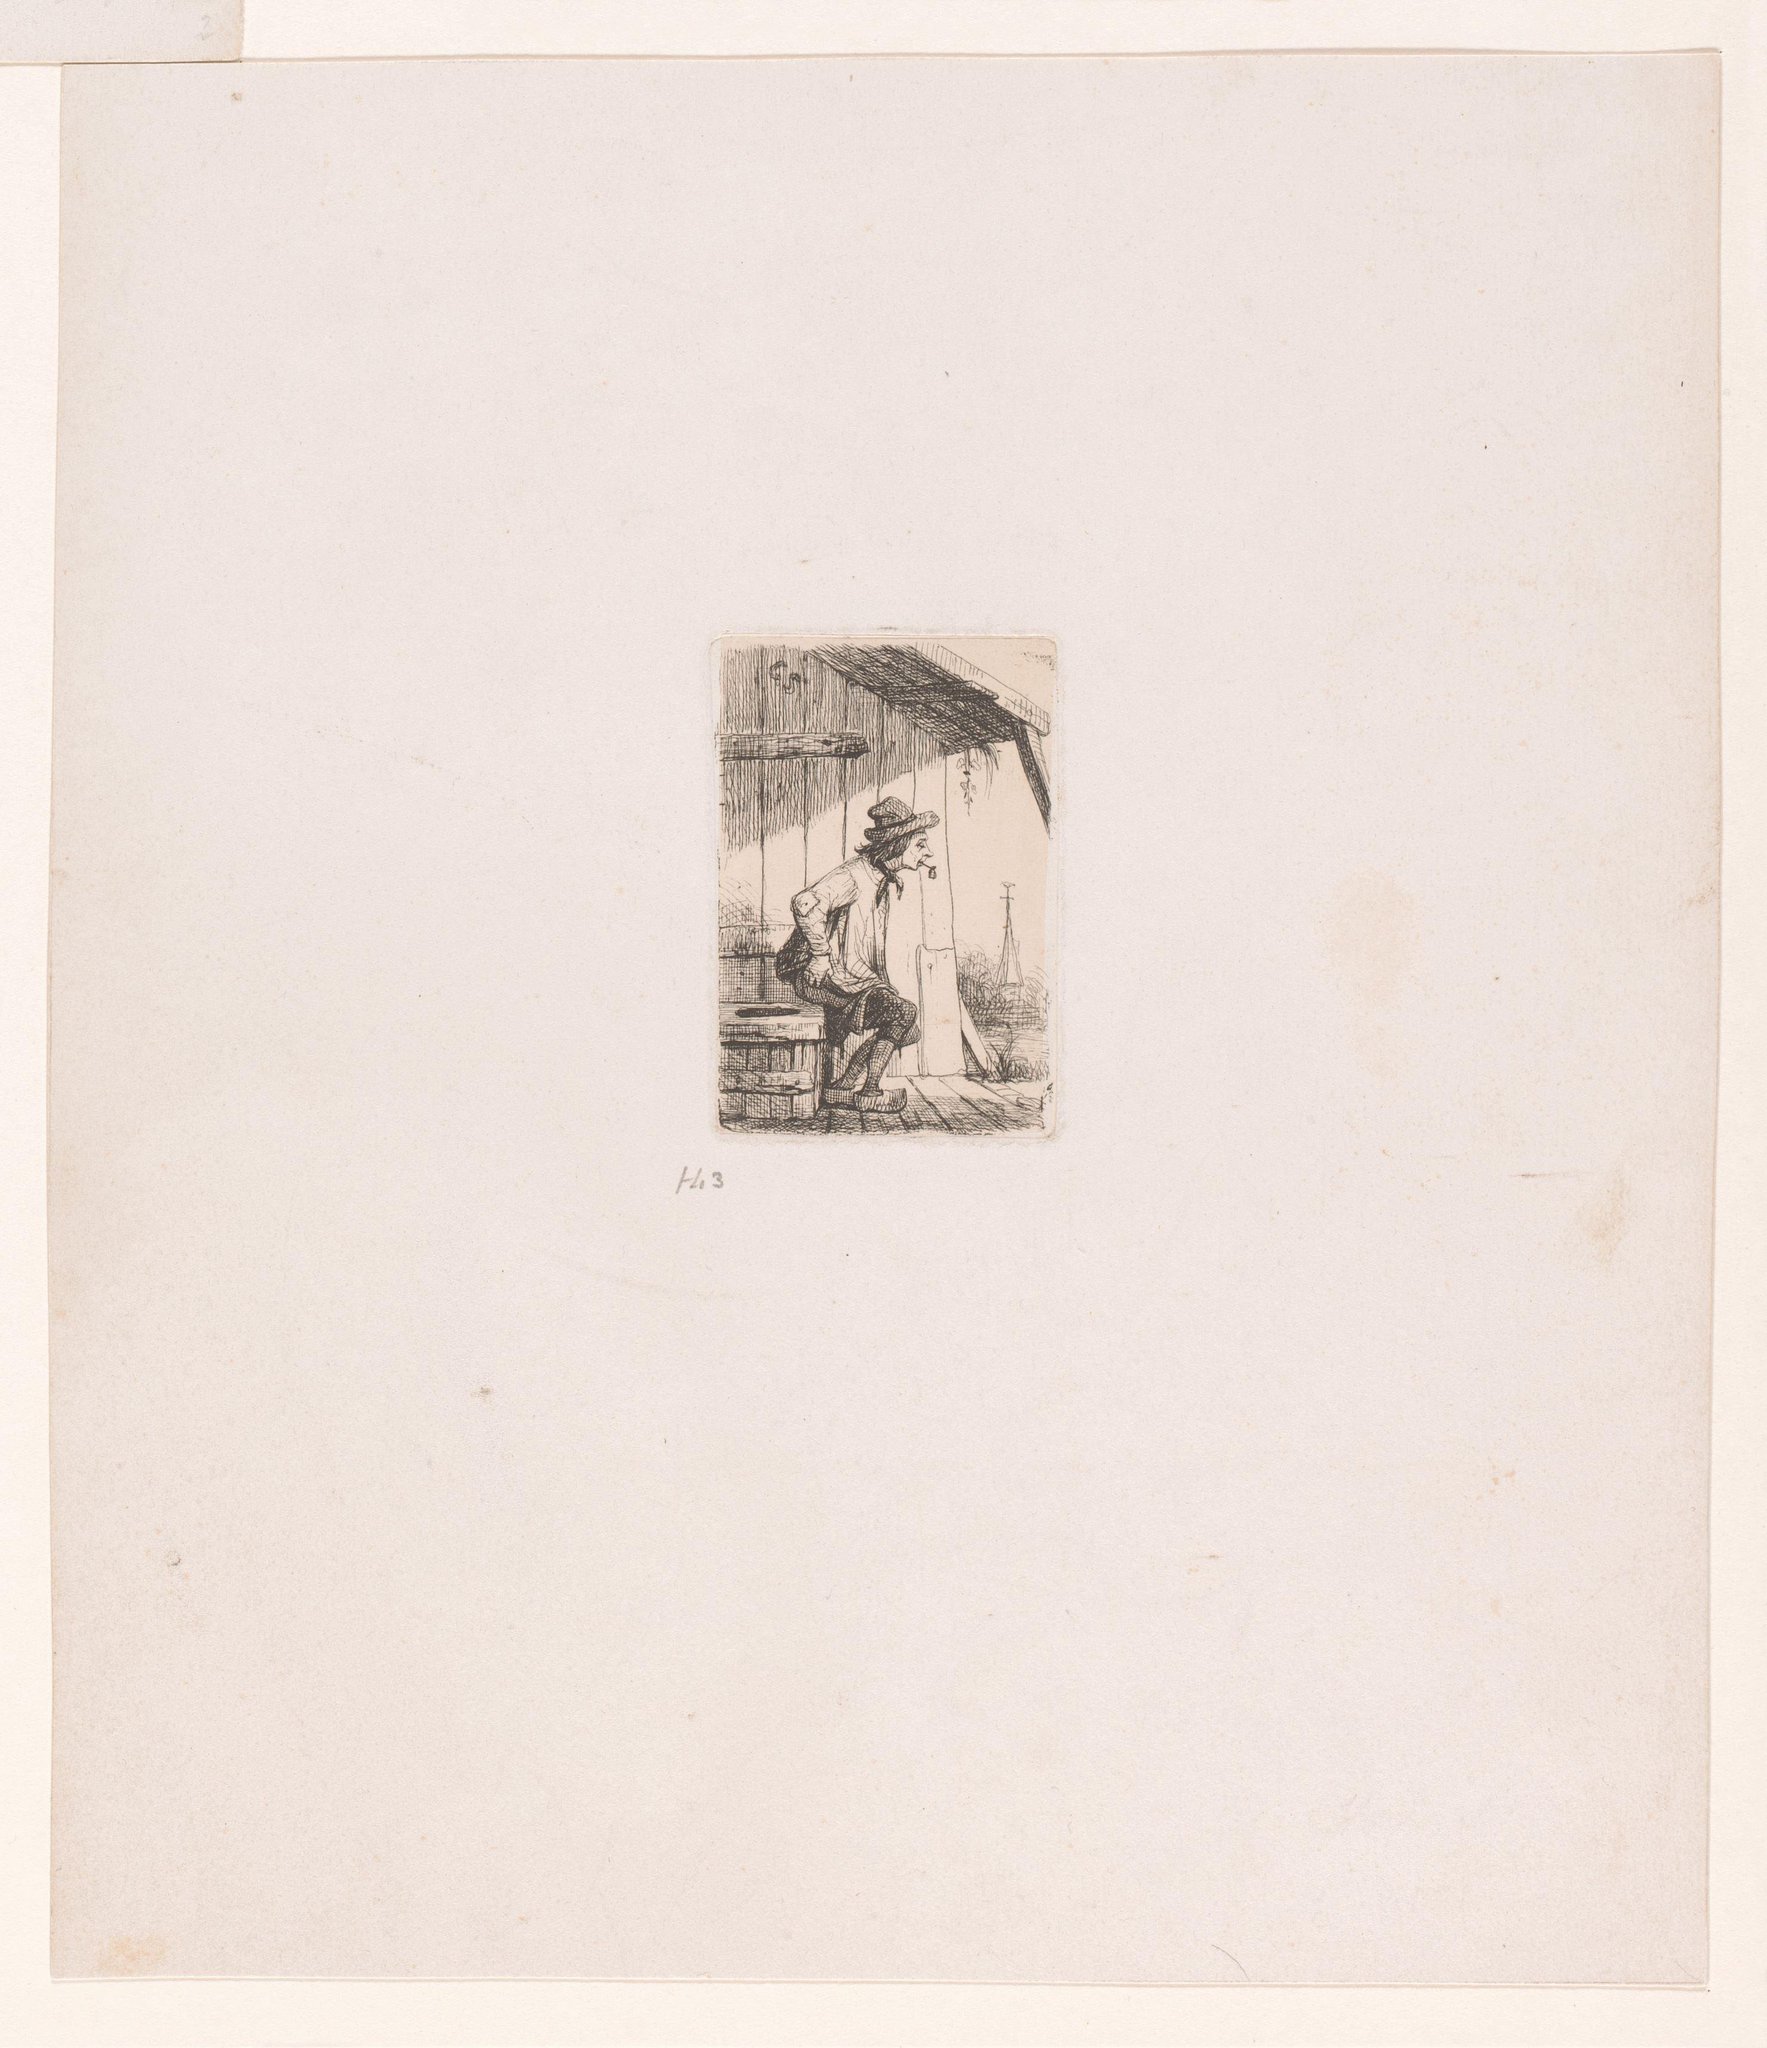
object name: print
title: Boer hijst zijn broek op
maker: corneille seghers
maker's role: draughtsman, print maker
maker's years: 1814-1869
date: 1824-1869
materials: paper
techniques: etching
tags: underclothes, farmers, defecation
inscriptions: collector's mark: Lugt 2228